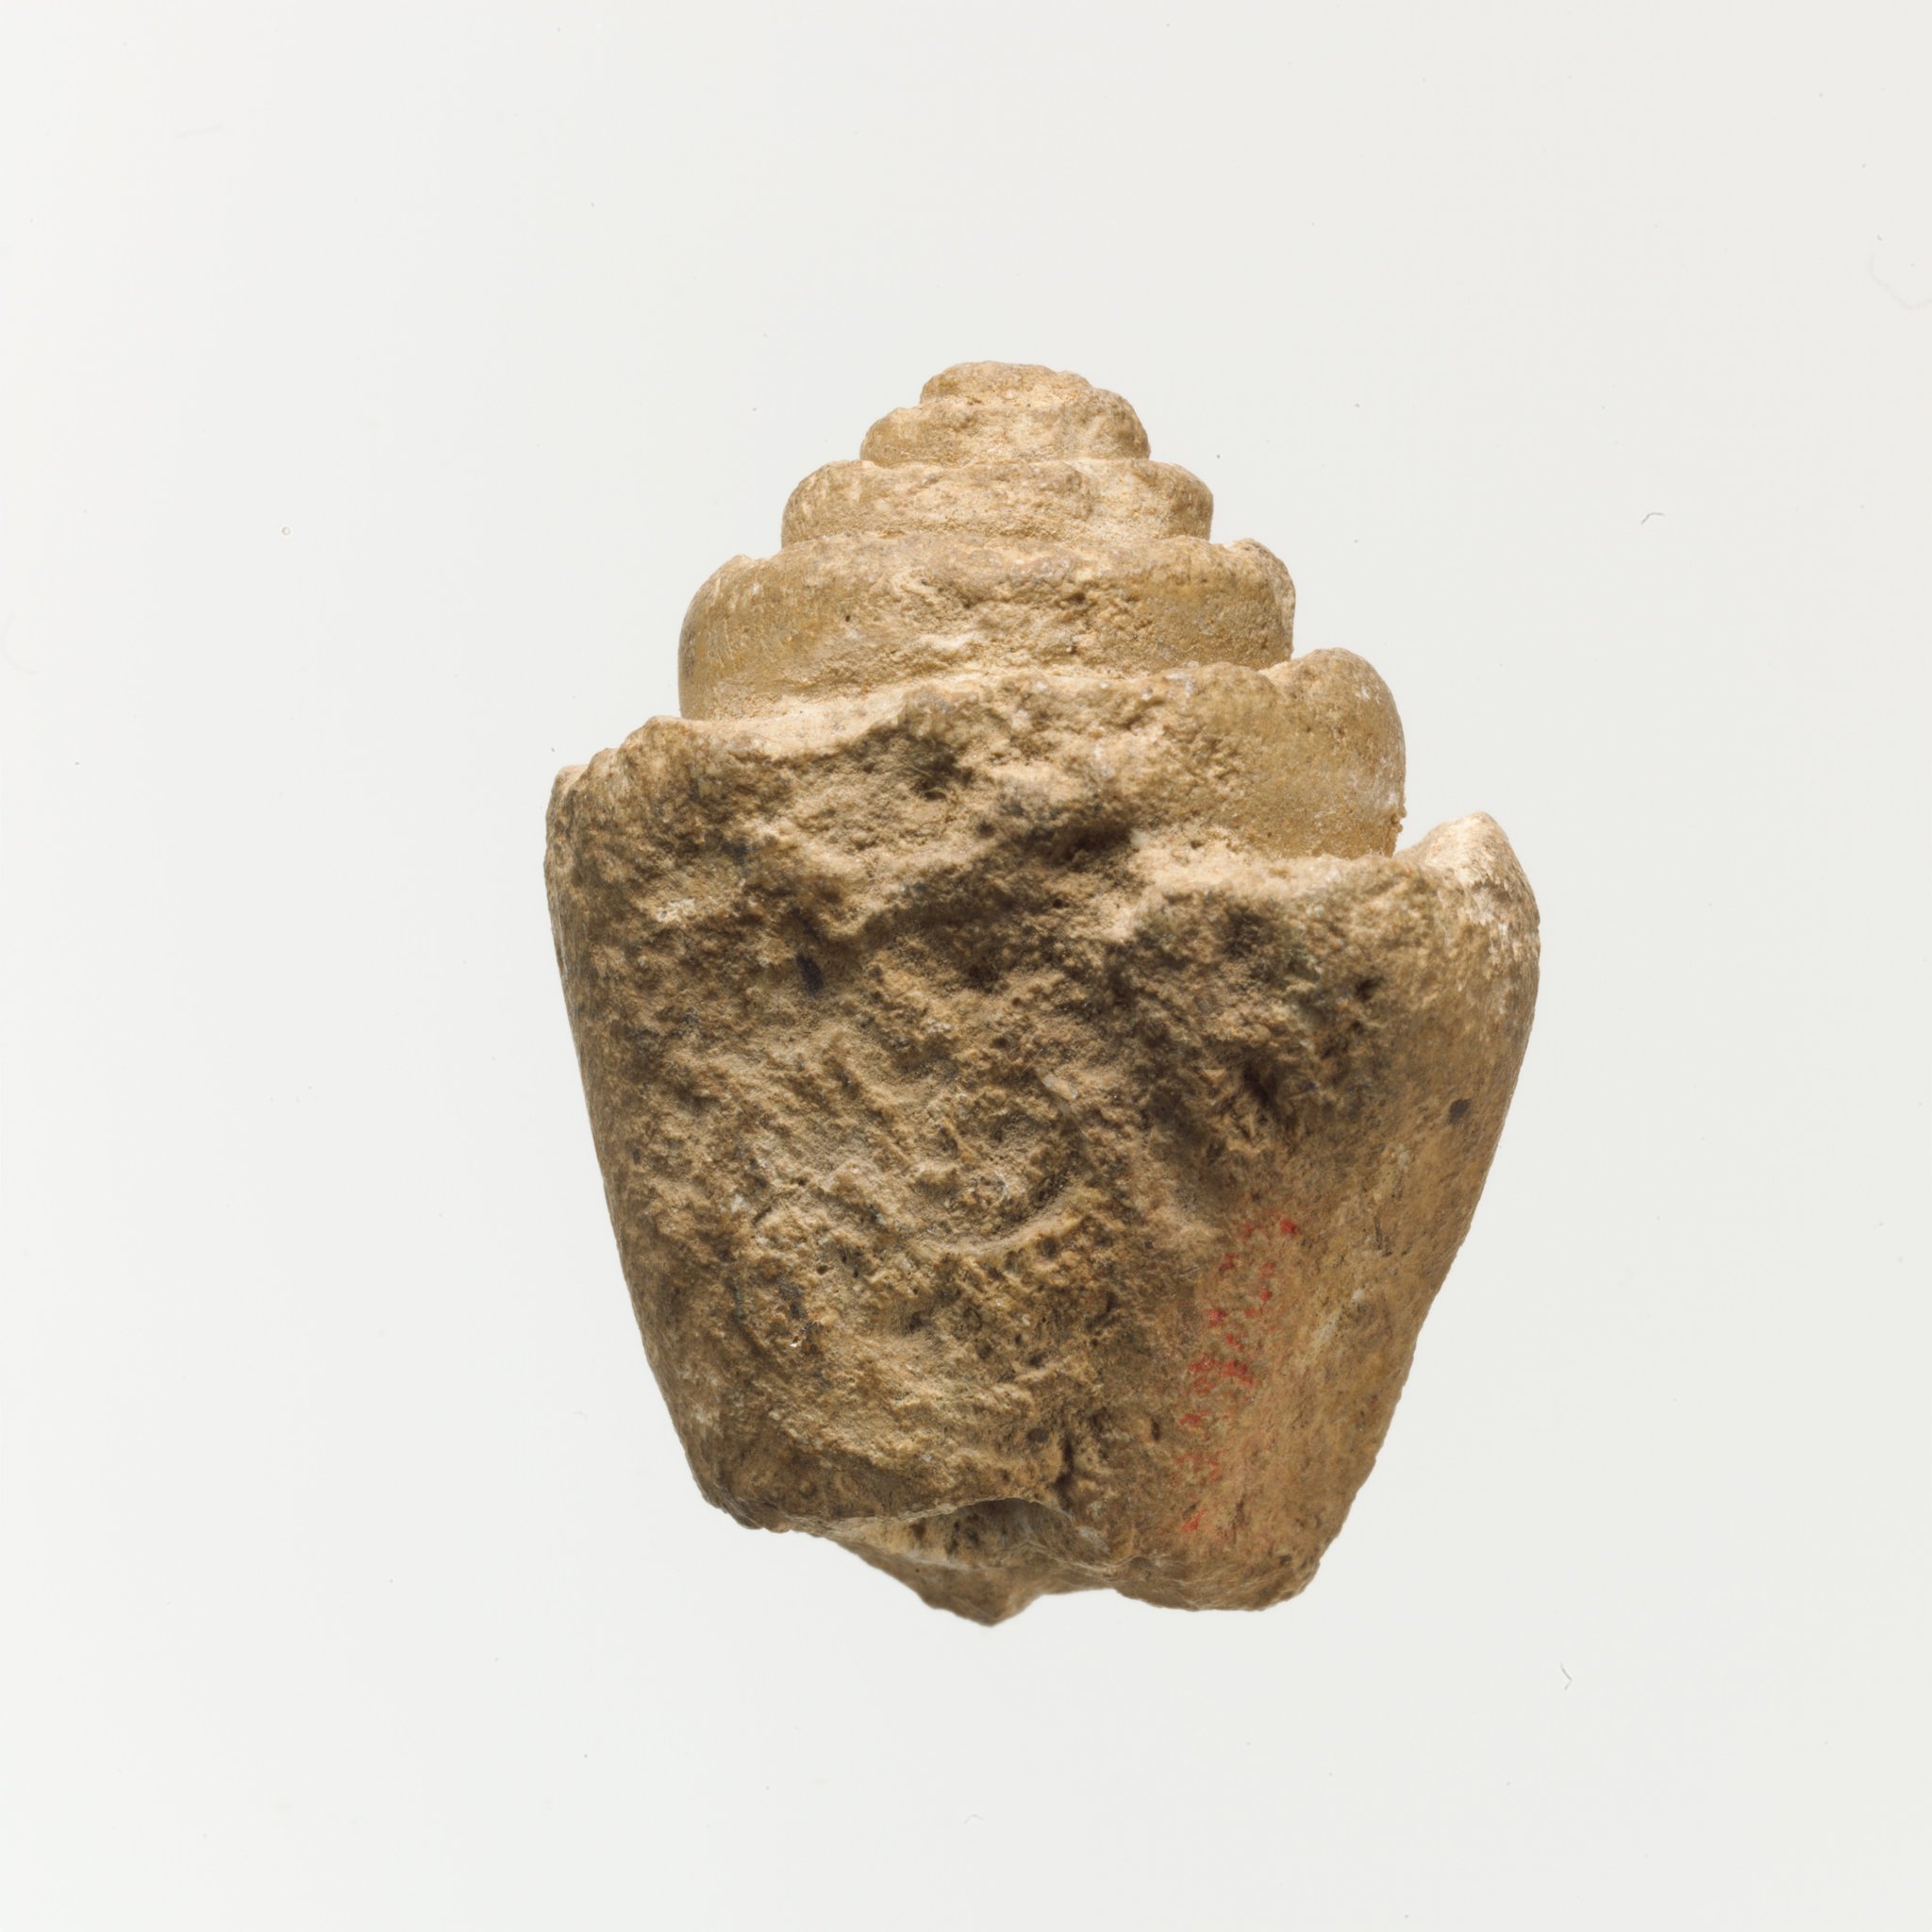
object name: shell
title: Terracotta shell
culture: minoan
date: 2200-1050 BCE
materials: clay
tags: shells